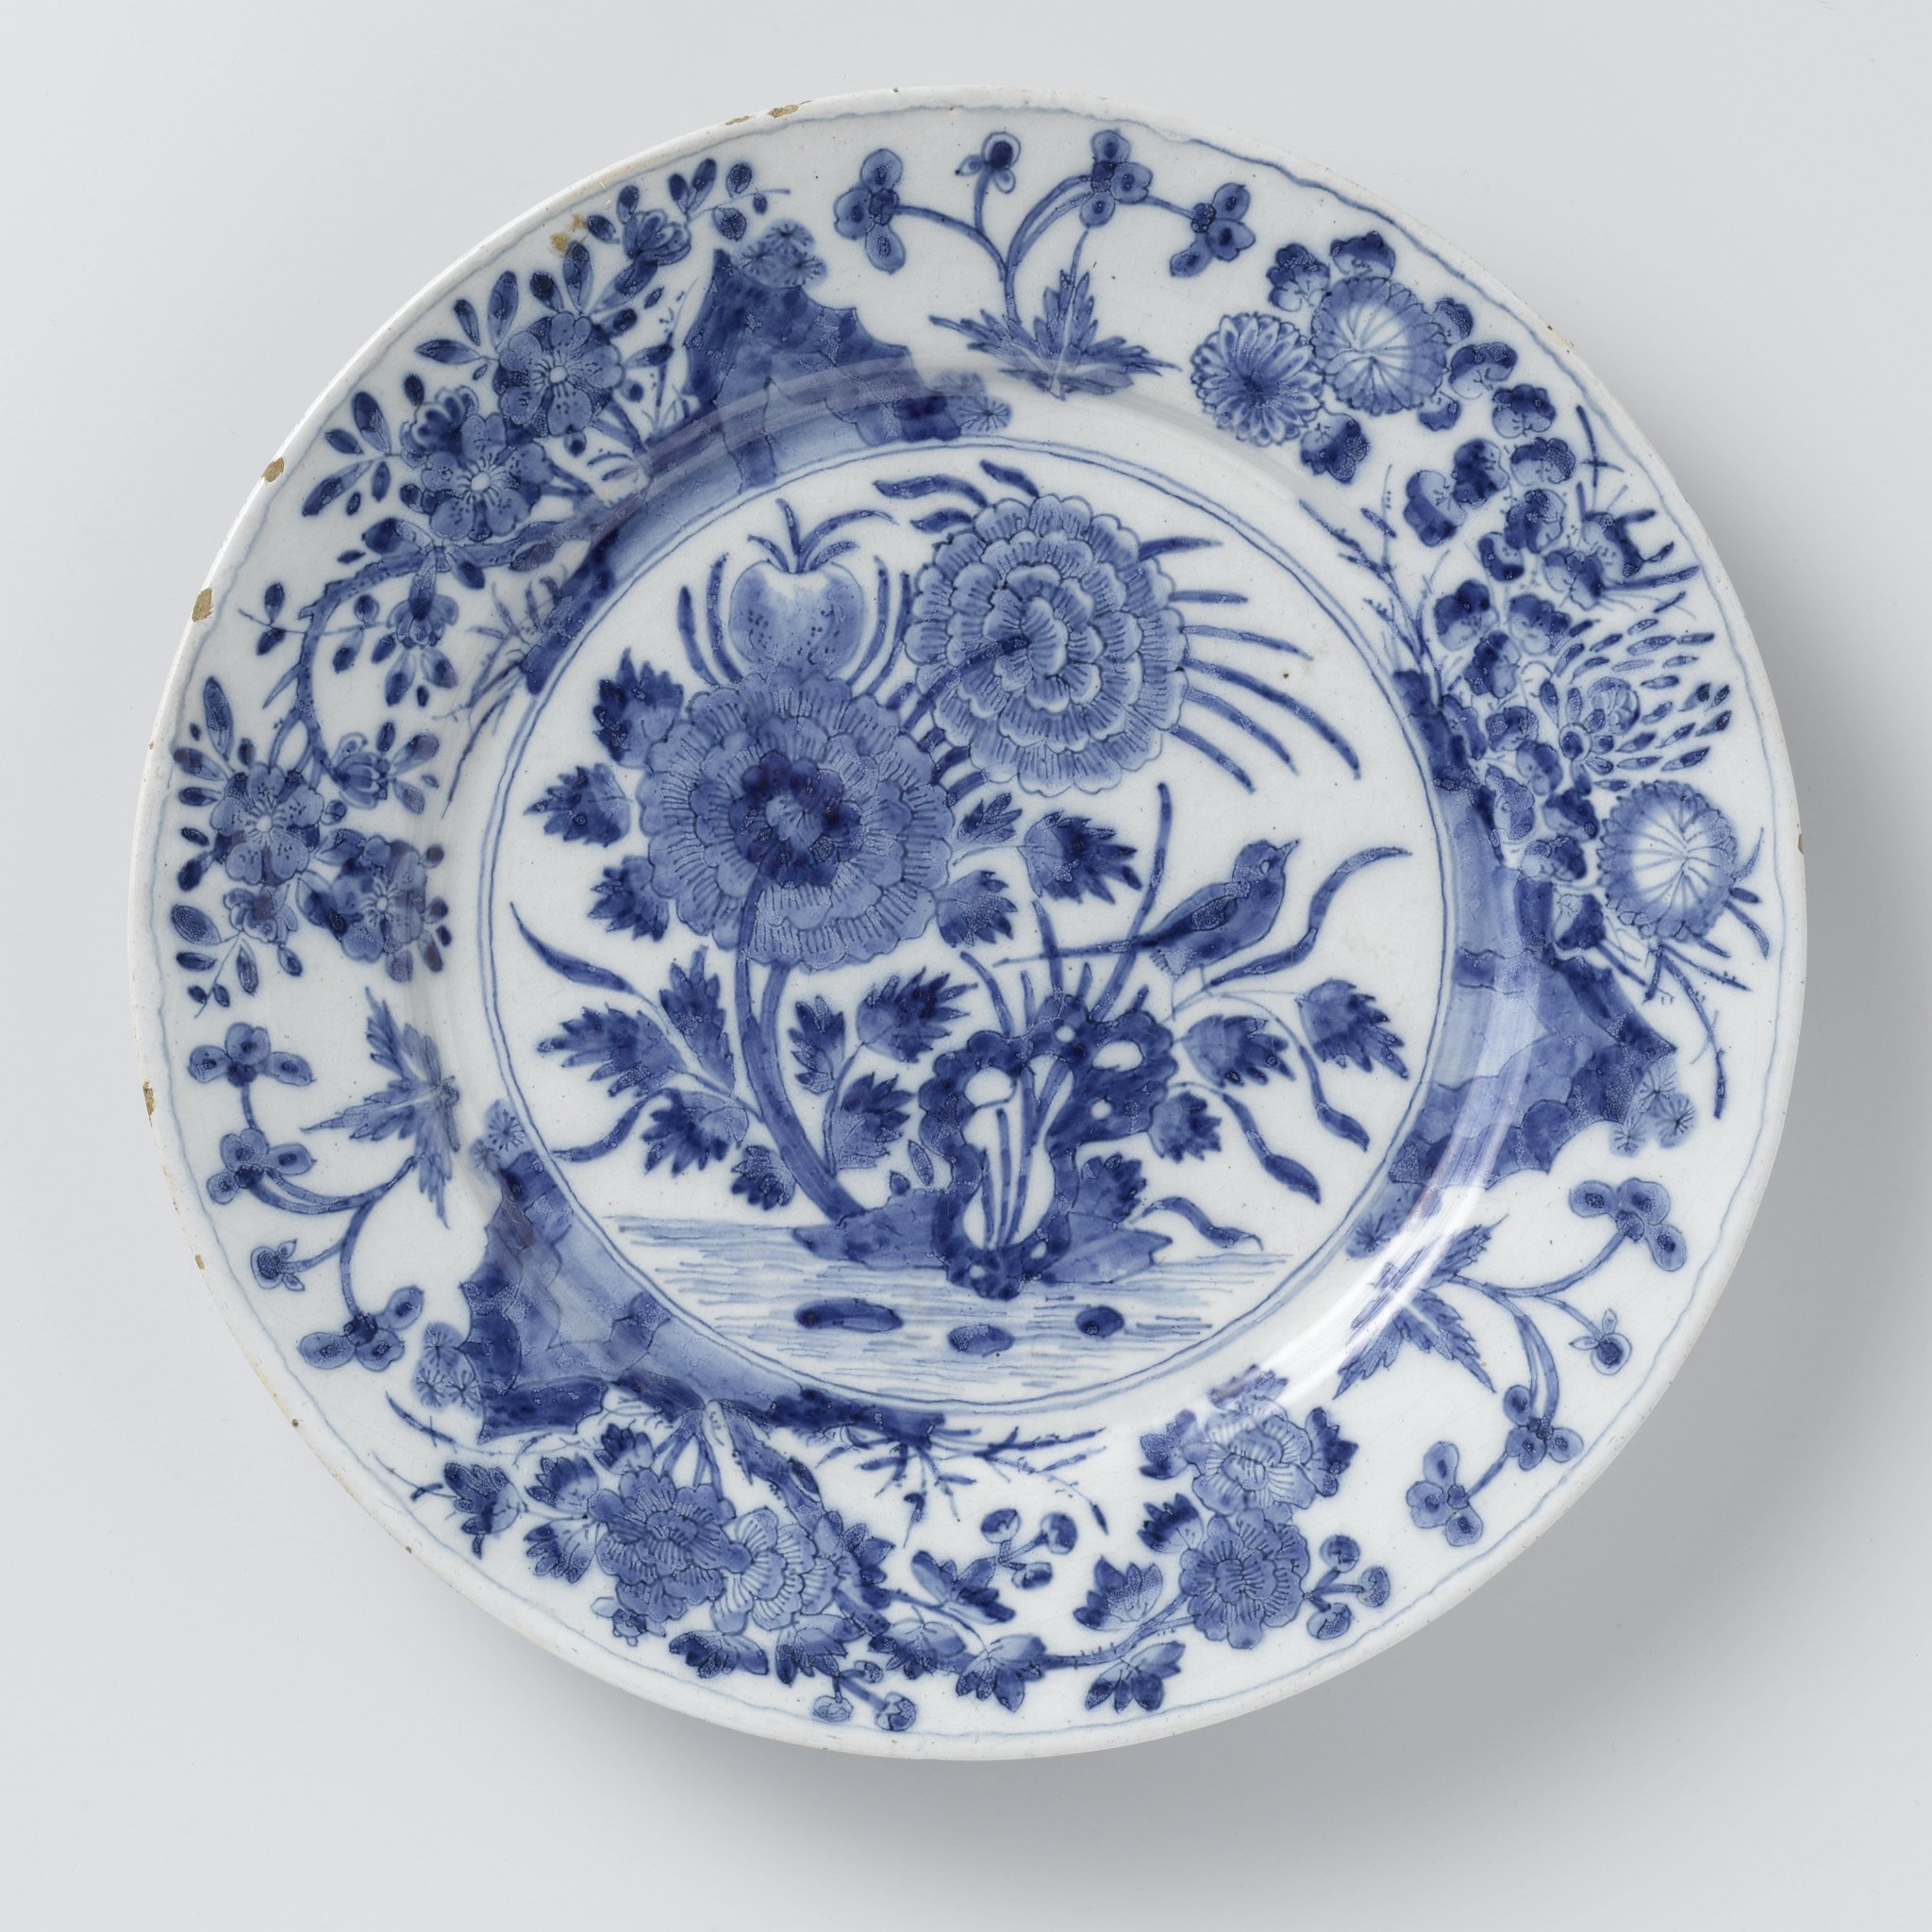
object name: plate dish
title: Bord van faïence met bloemdecoratie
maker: Anonymous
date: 1685-1710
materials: faience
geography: delft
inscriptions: mark: ‘figuratief merk in de vorm Chinese ding (wierrookbrander)’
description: Bord van faïence. Blauw beschilderd met een op het Chinese porselein geïnspireerde bloemdecoratie.